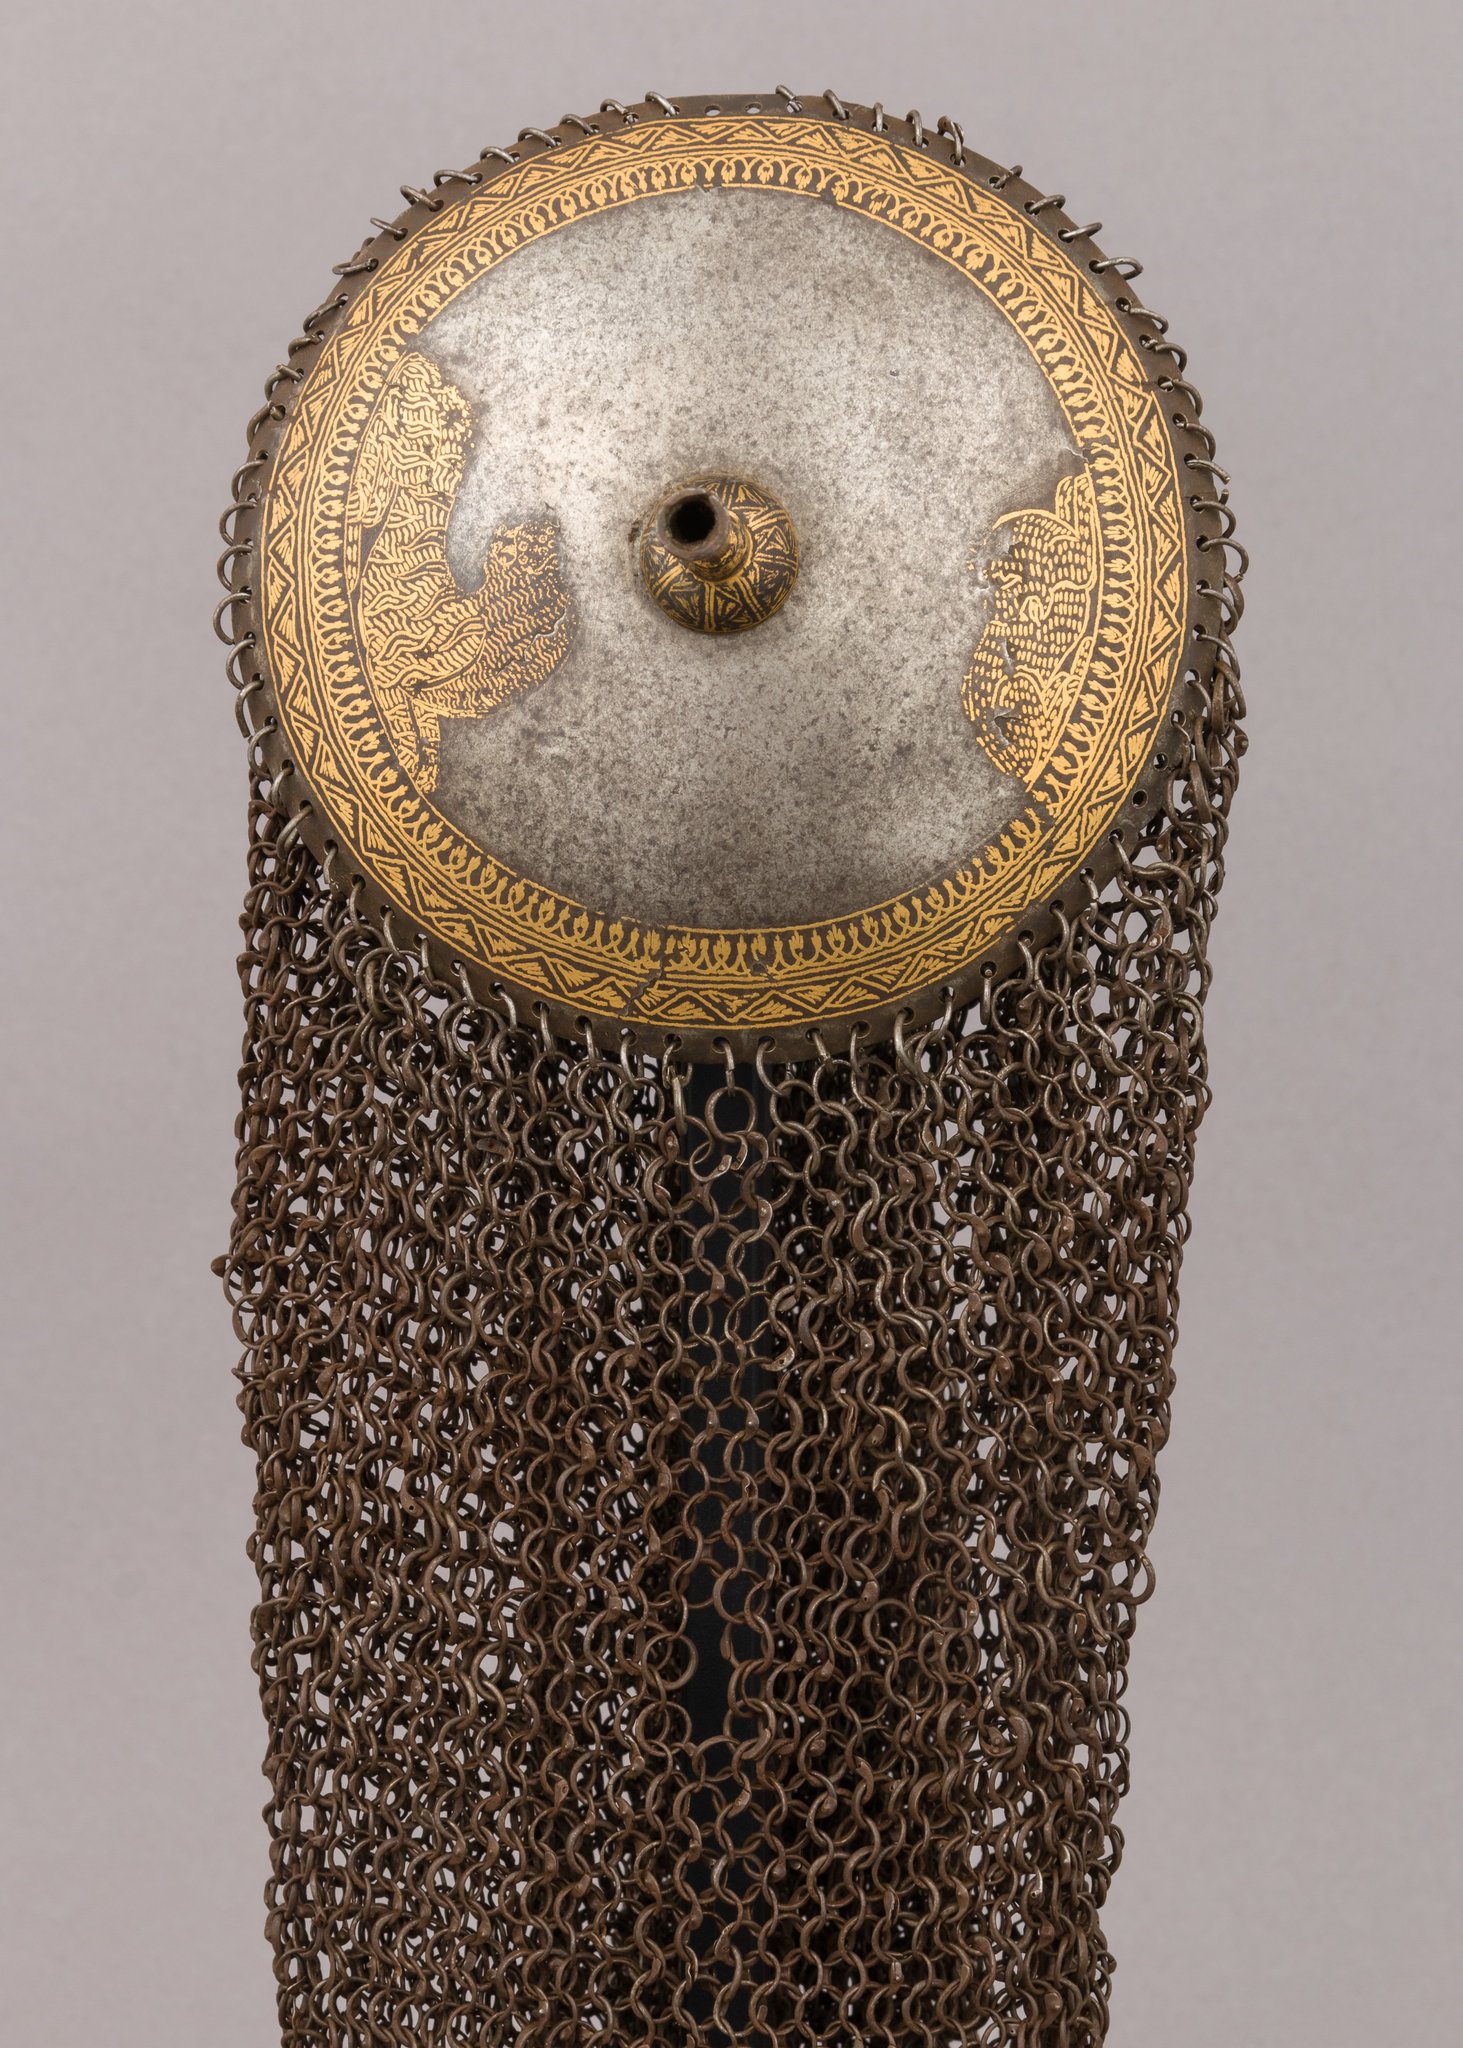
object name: helmet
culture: indian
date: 1701-1800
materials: gold, steel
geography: china